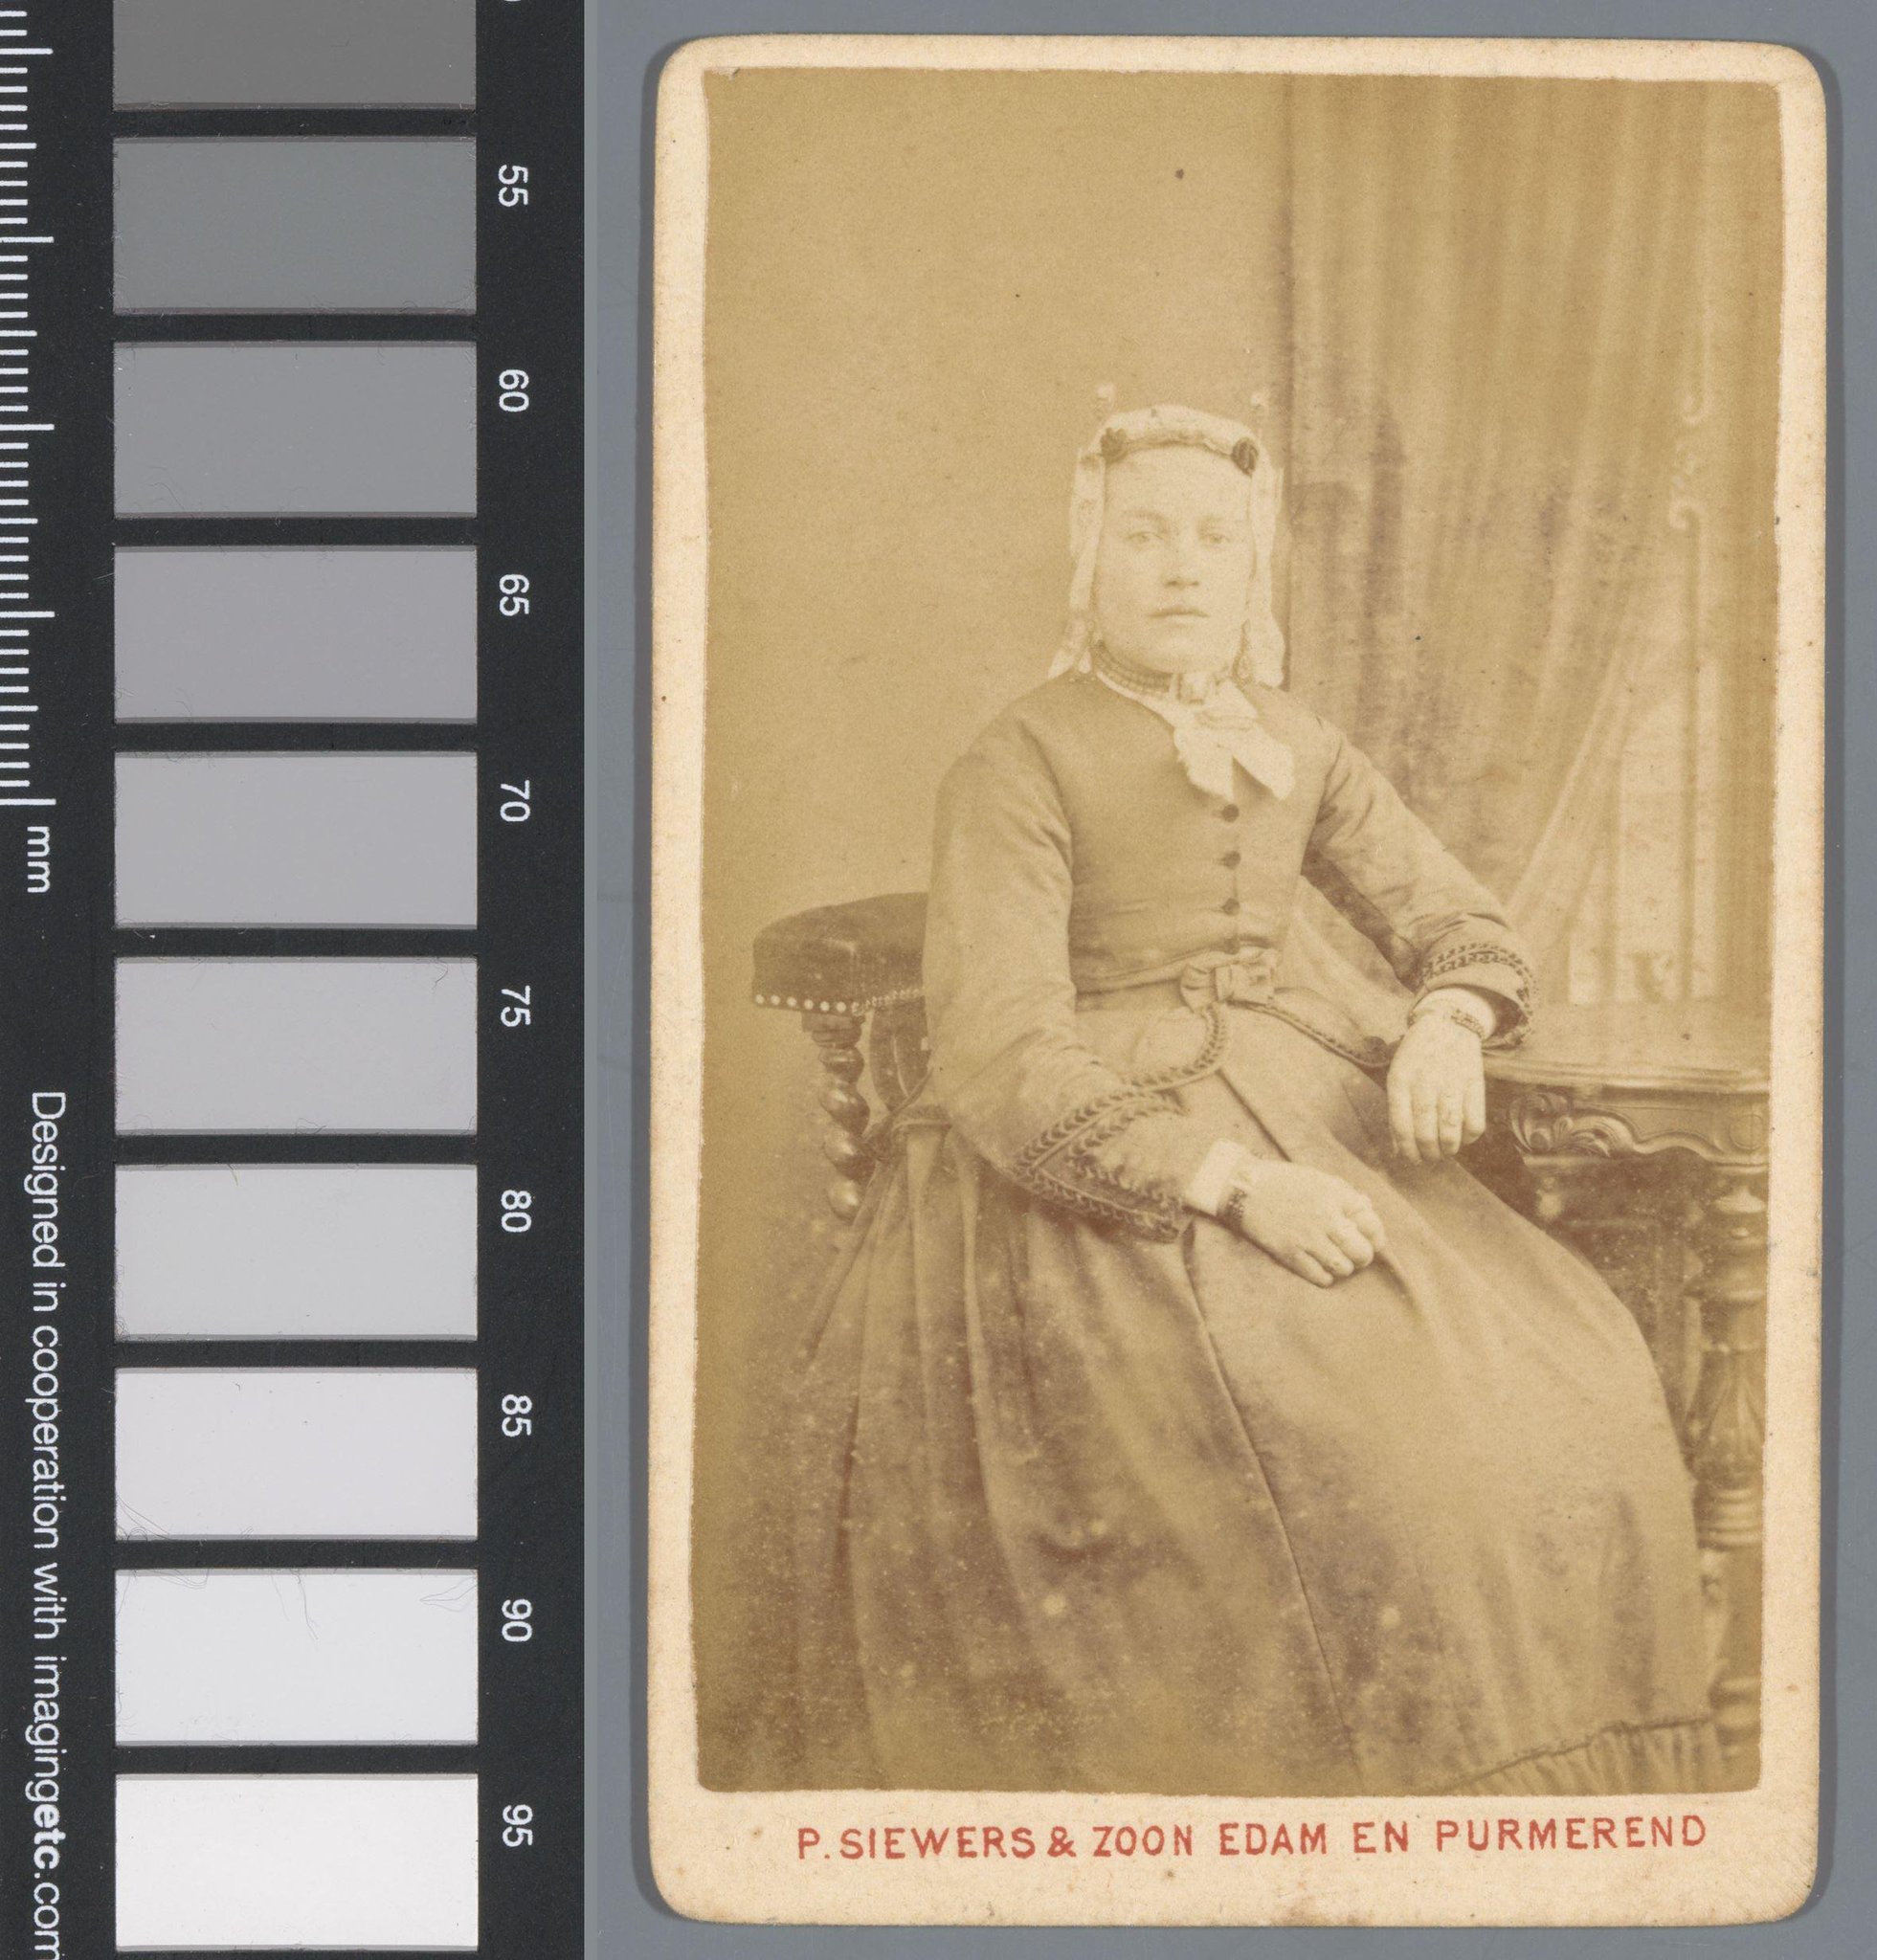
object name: carte de visite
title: Portret van Geertje Vink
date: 1857-1898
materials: cardboard, paper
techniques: albumen print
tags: sitting figure, historical persons - bb - woman, head-gear: cap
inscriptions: inscription: ‘Photographisch/ ATELIER/ P. Sieuwers & Zoon/ EDAM/ EN/ PURMEREND/ Te Edam dagelijks werkzaam/ Te Purmerend zondag & dinsdag/ de negatieven blijven bewaard tot nabestelling’, inscription: ‘Geertje Vink van K. Ton’